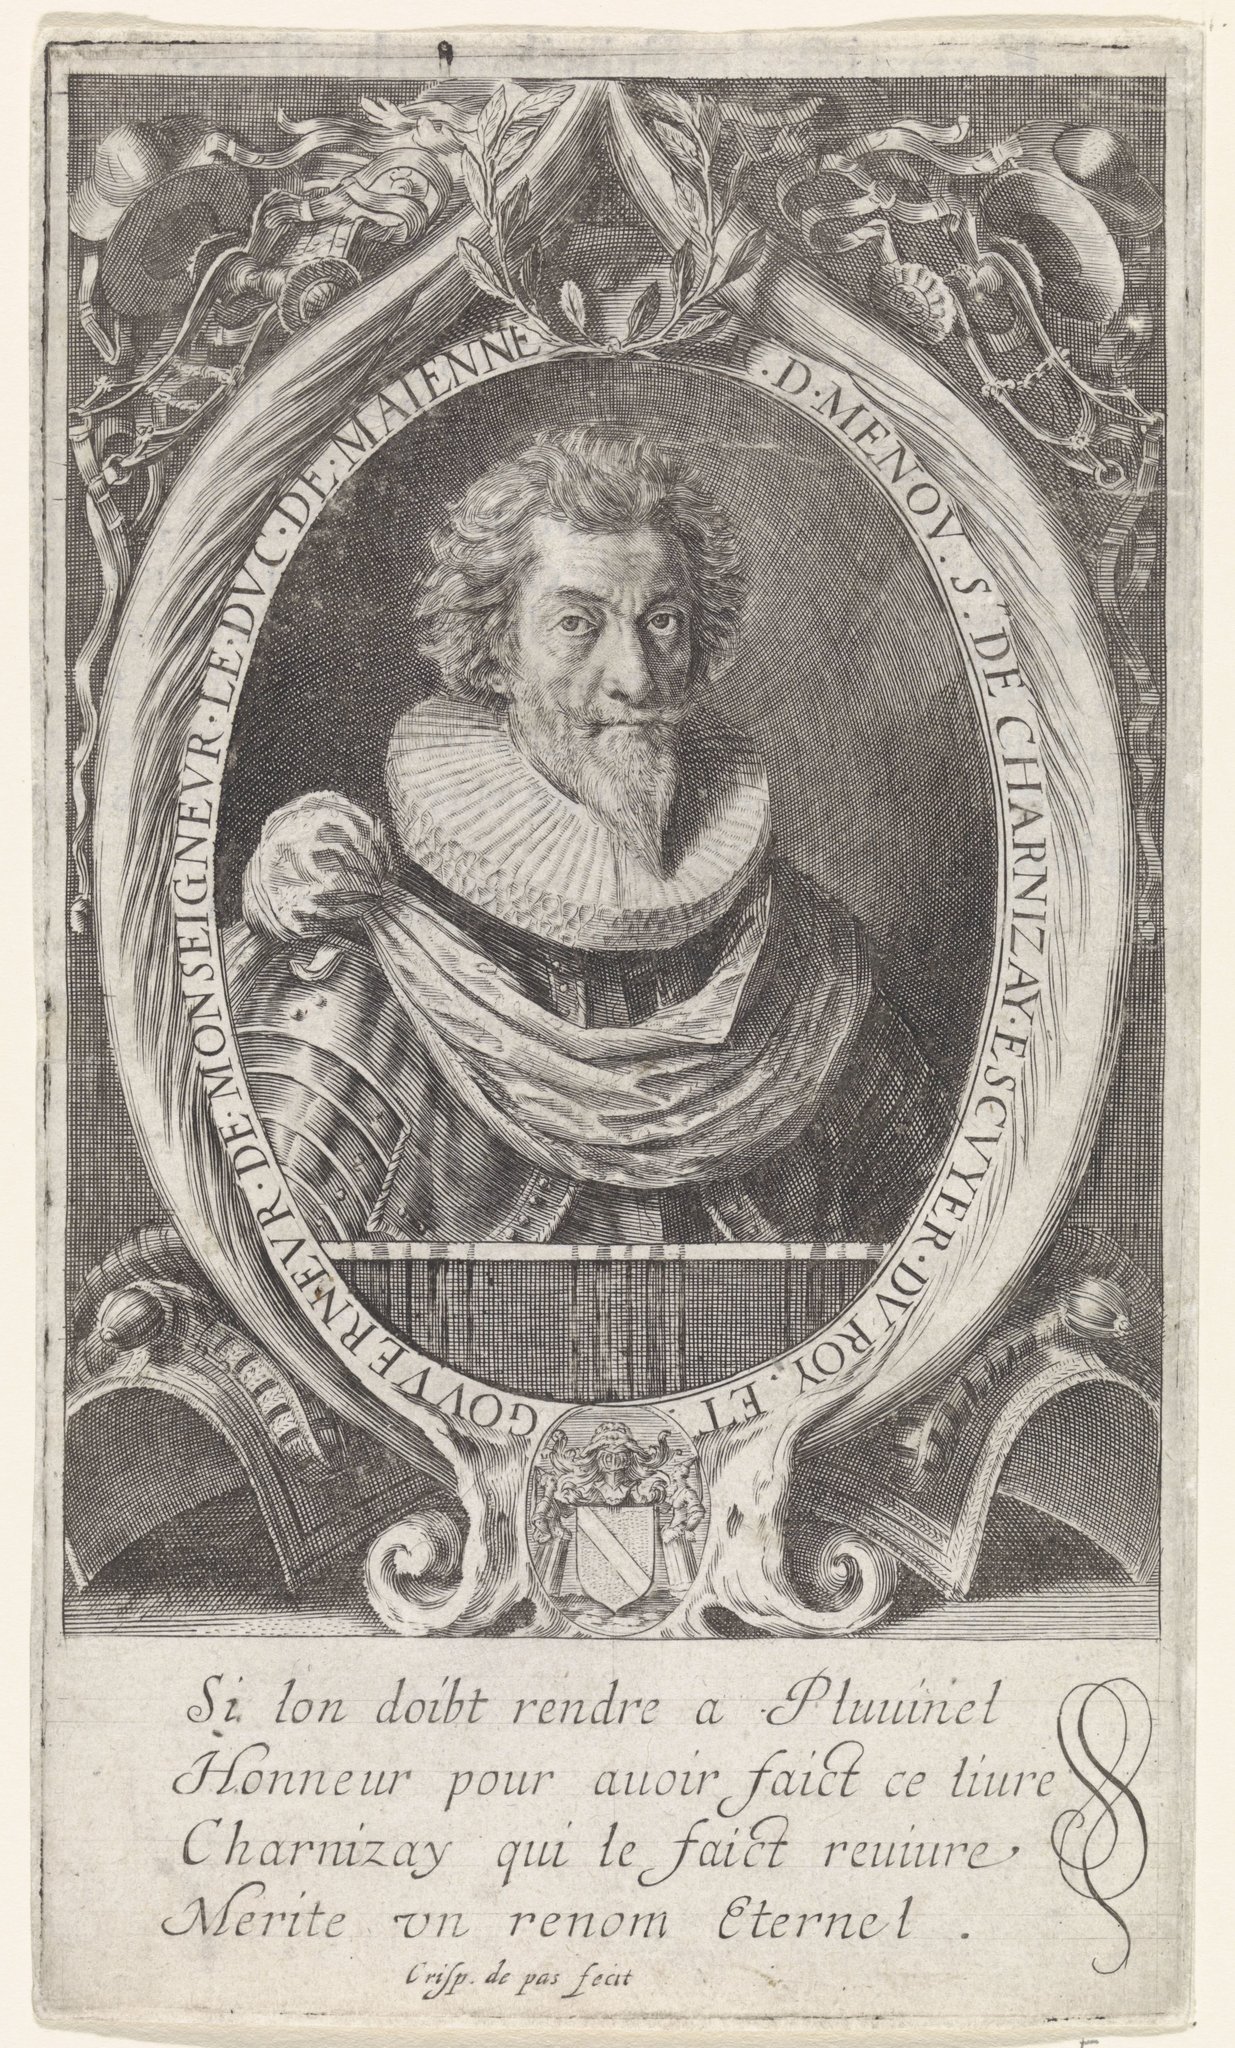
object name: print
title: Portret van René de Menou, graaf van Charnizay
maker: crispijn van de passe (ii)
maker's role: draughtsman, print maker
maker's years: 1594-1670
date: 1625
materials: paper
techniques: engraving, letterpress printing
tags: saddle and bridle (saddlery)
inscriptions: collector's mark: Lugt 2228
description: Portret van René de Menou, graaf van Charnizay. In het randschrift van de omlijsting de naam en functie van de geportretteerde in het Frans. Onderaan de omlijsting het wapenschild van de geportretteerde. In de hoeken zadels en hoofdstellen. In de marge een vierregelig lofdicht in het Frans. Op de versozijde boekdruk in het Frans.